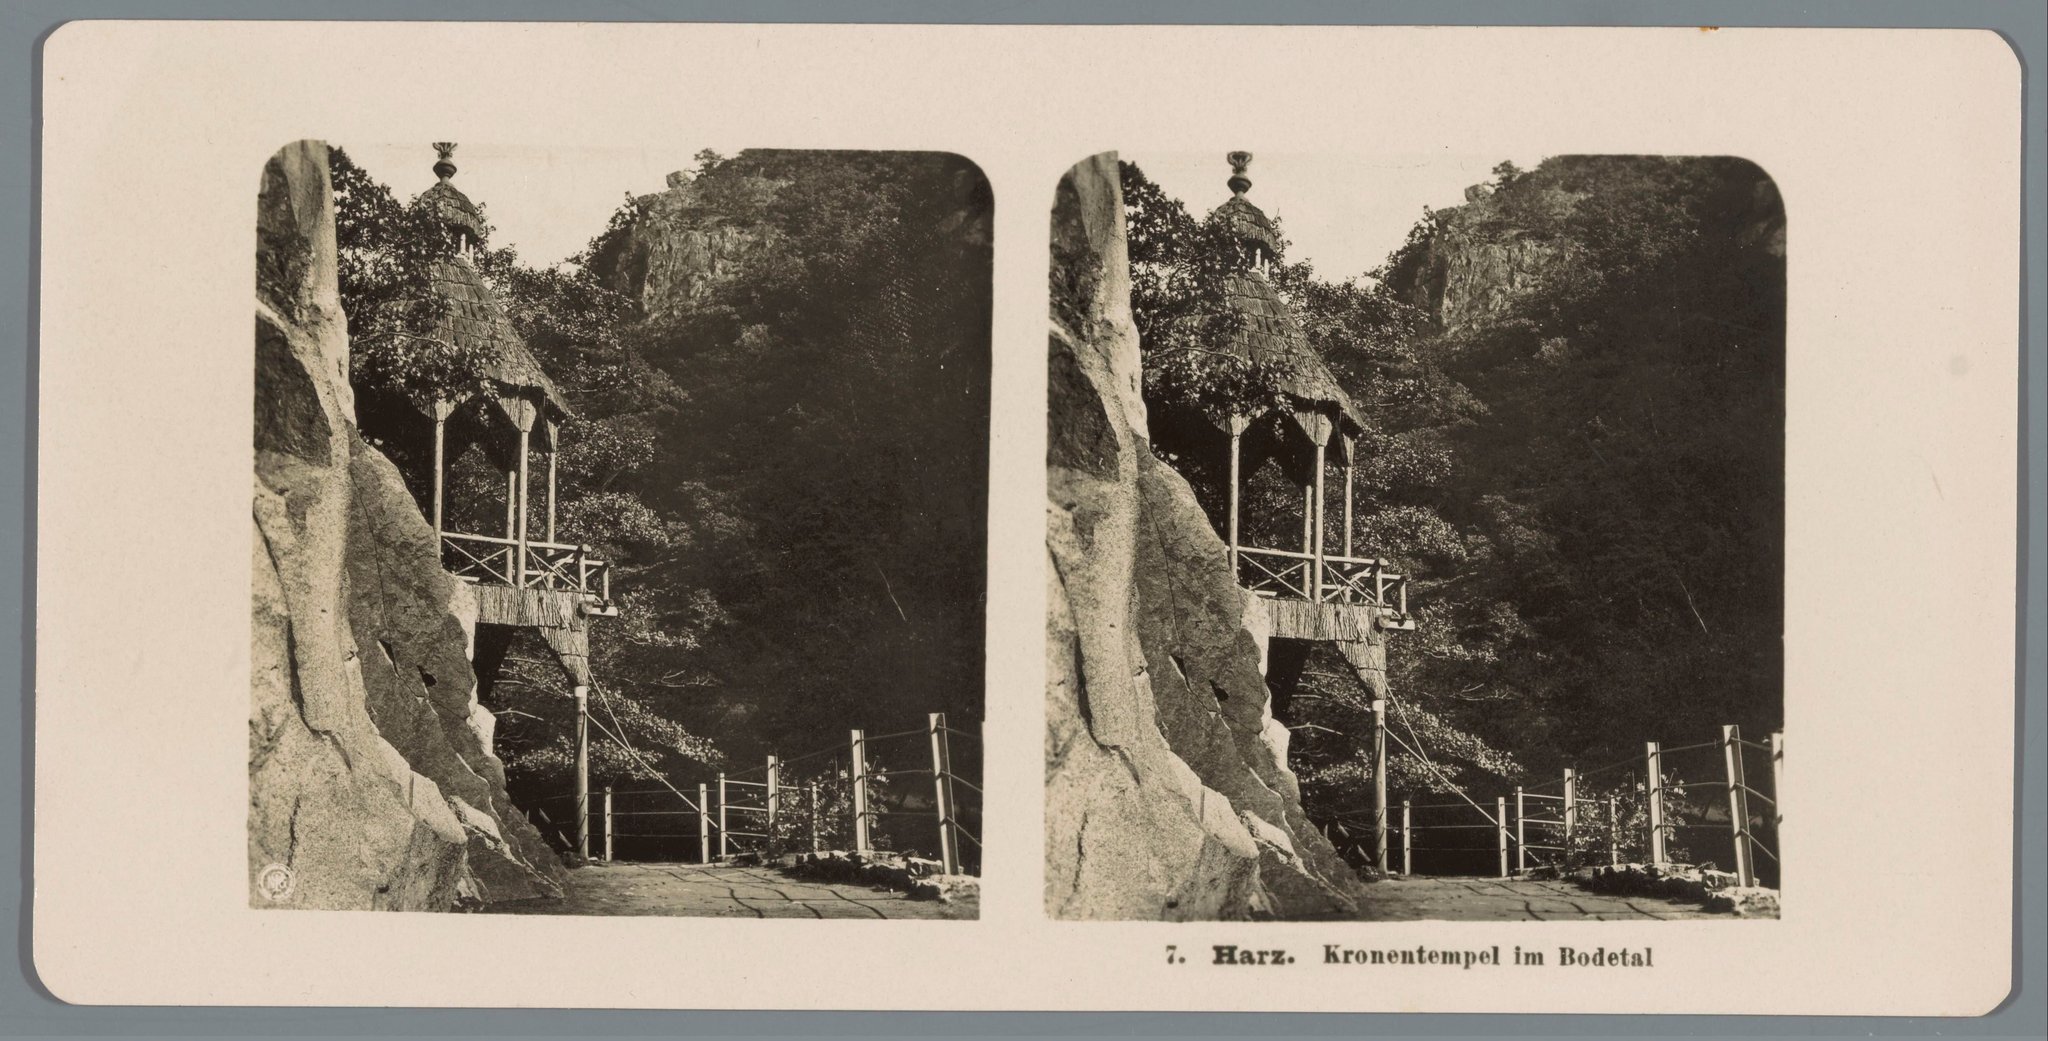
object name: stereograph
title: Kronentempel in het Bodetal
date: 1900-1910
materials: cardboard, photographic support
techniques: gelatin silver print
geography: bodetal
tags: dale, valley, summer-house, arbour, garden-house (dutch: 'theekoepel')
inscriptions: inscription: ‘NPG’, number: ‘7.’